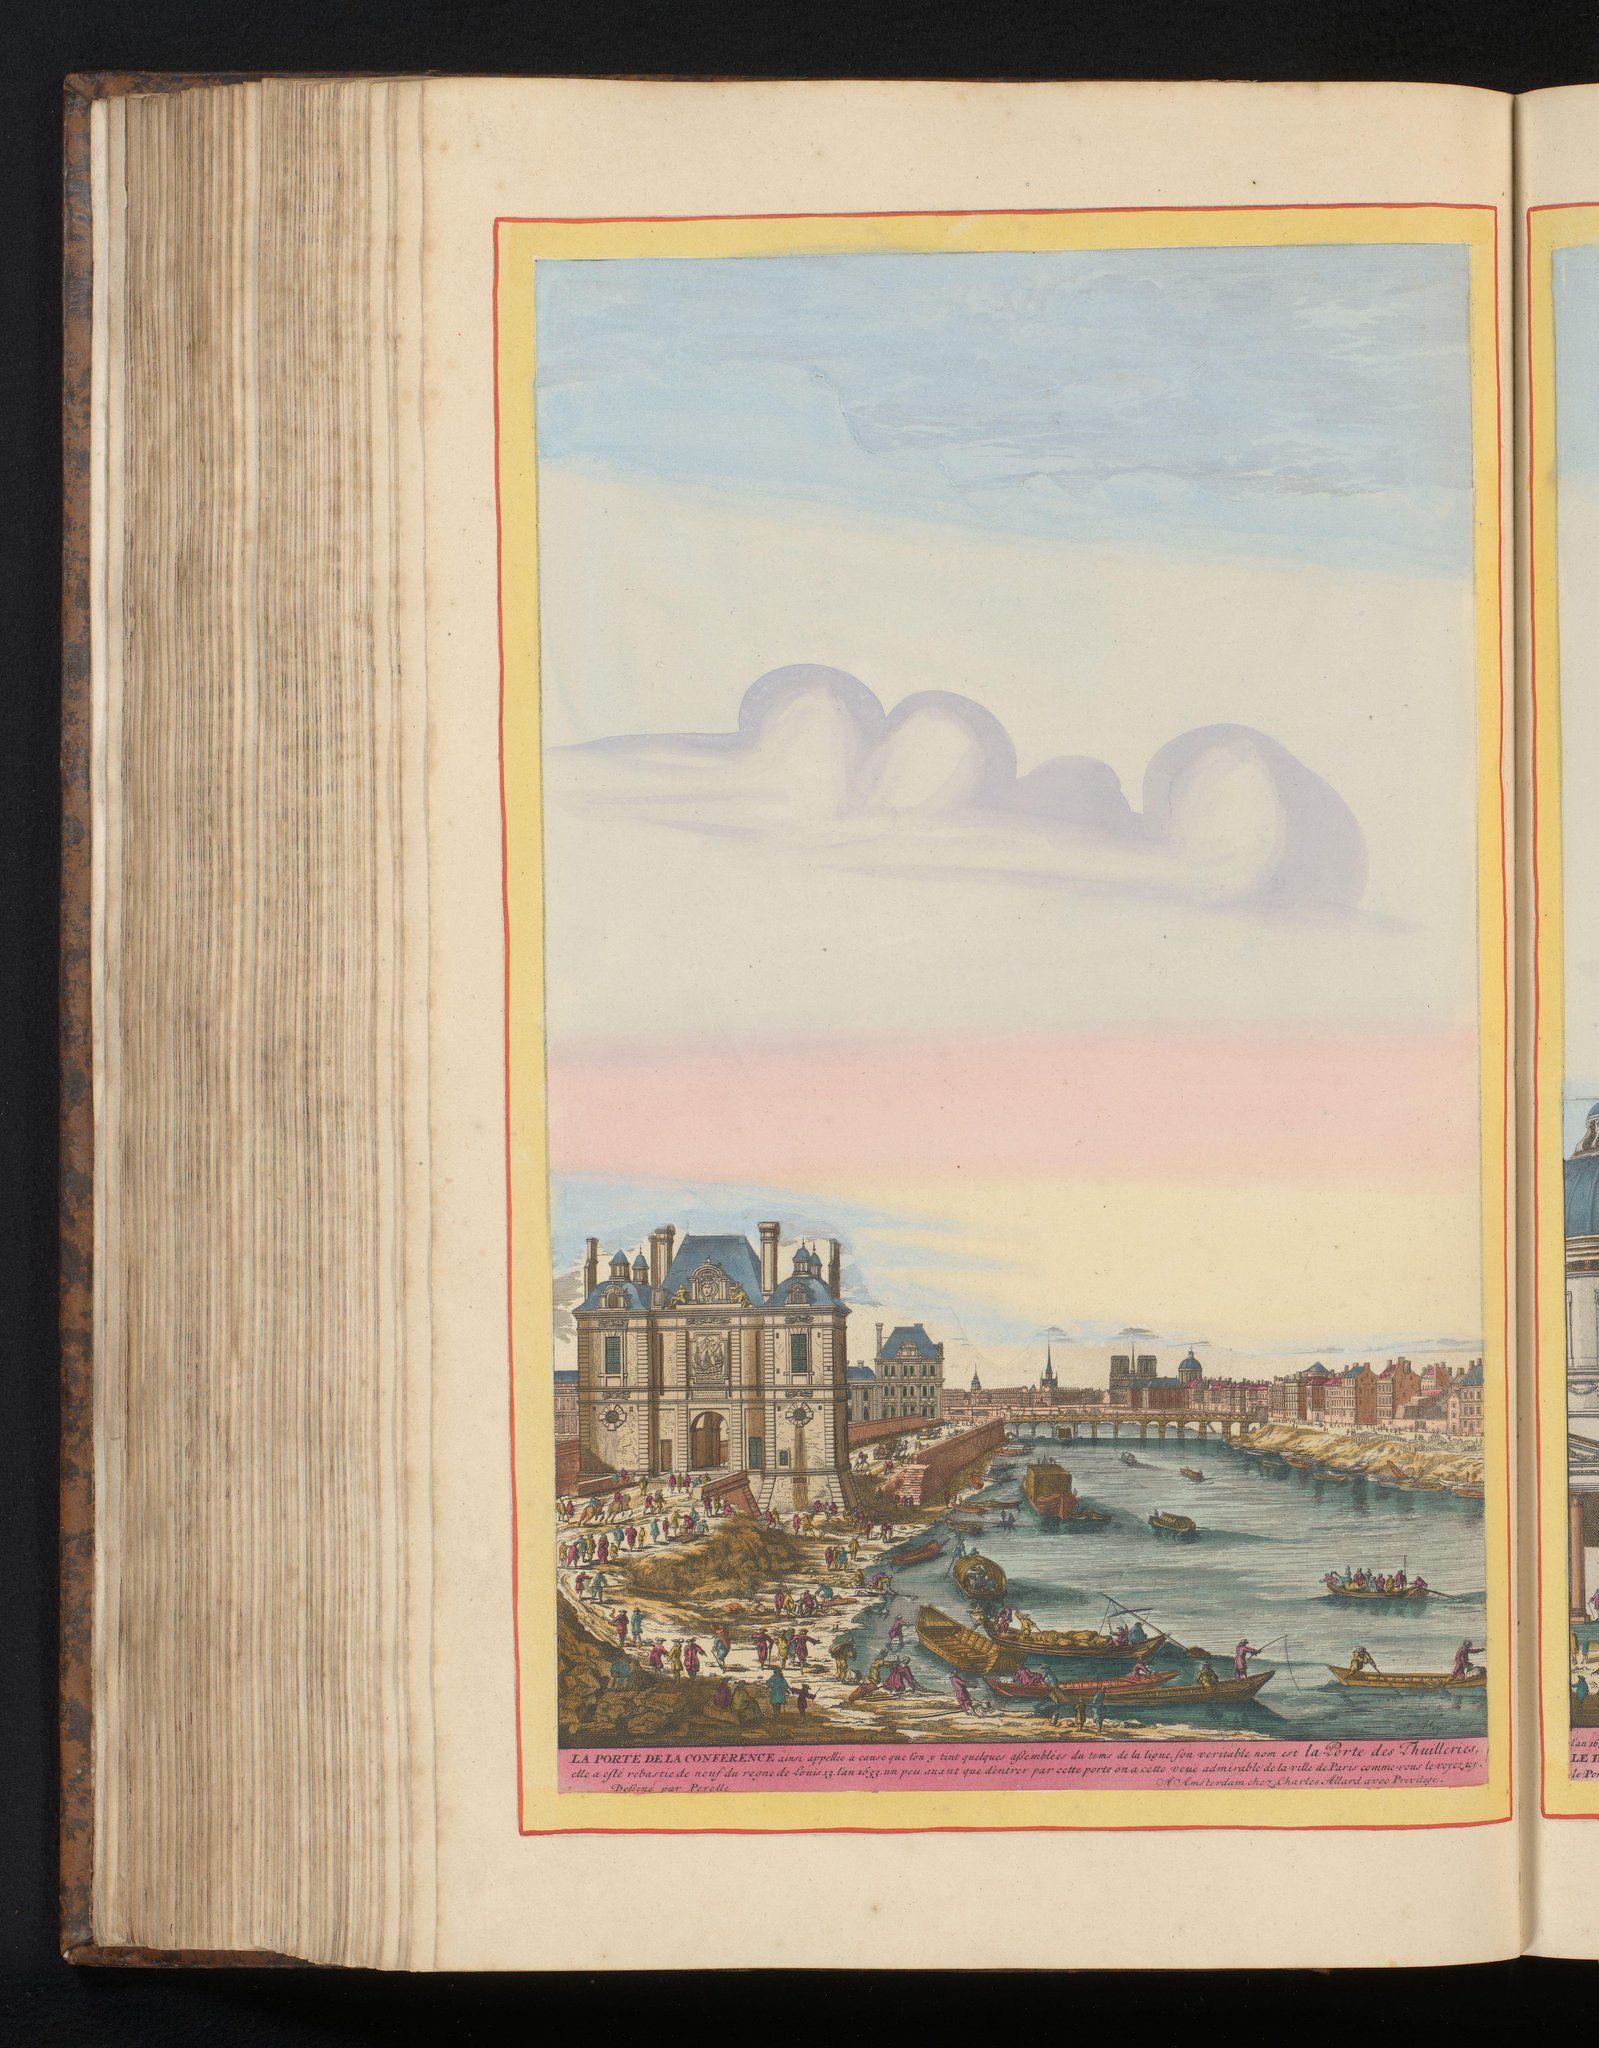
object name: print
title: Gezicht op de Porte de la Conférence en de Seine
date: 1685-1695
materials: paper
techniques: etching, hand coloring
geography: the hague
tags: village-gate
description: De prent is langs de bovenrand van de voorstelling afgescheurd. Het bovenste gedeelte is hoger opgeplakt, zodat de lucht hoger is geworden en het formaat van de voorstelling past bij de andere groot formaatvoorstellingen in het album.